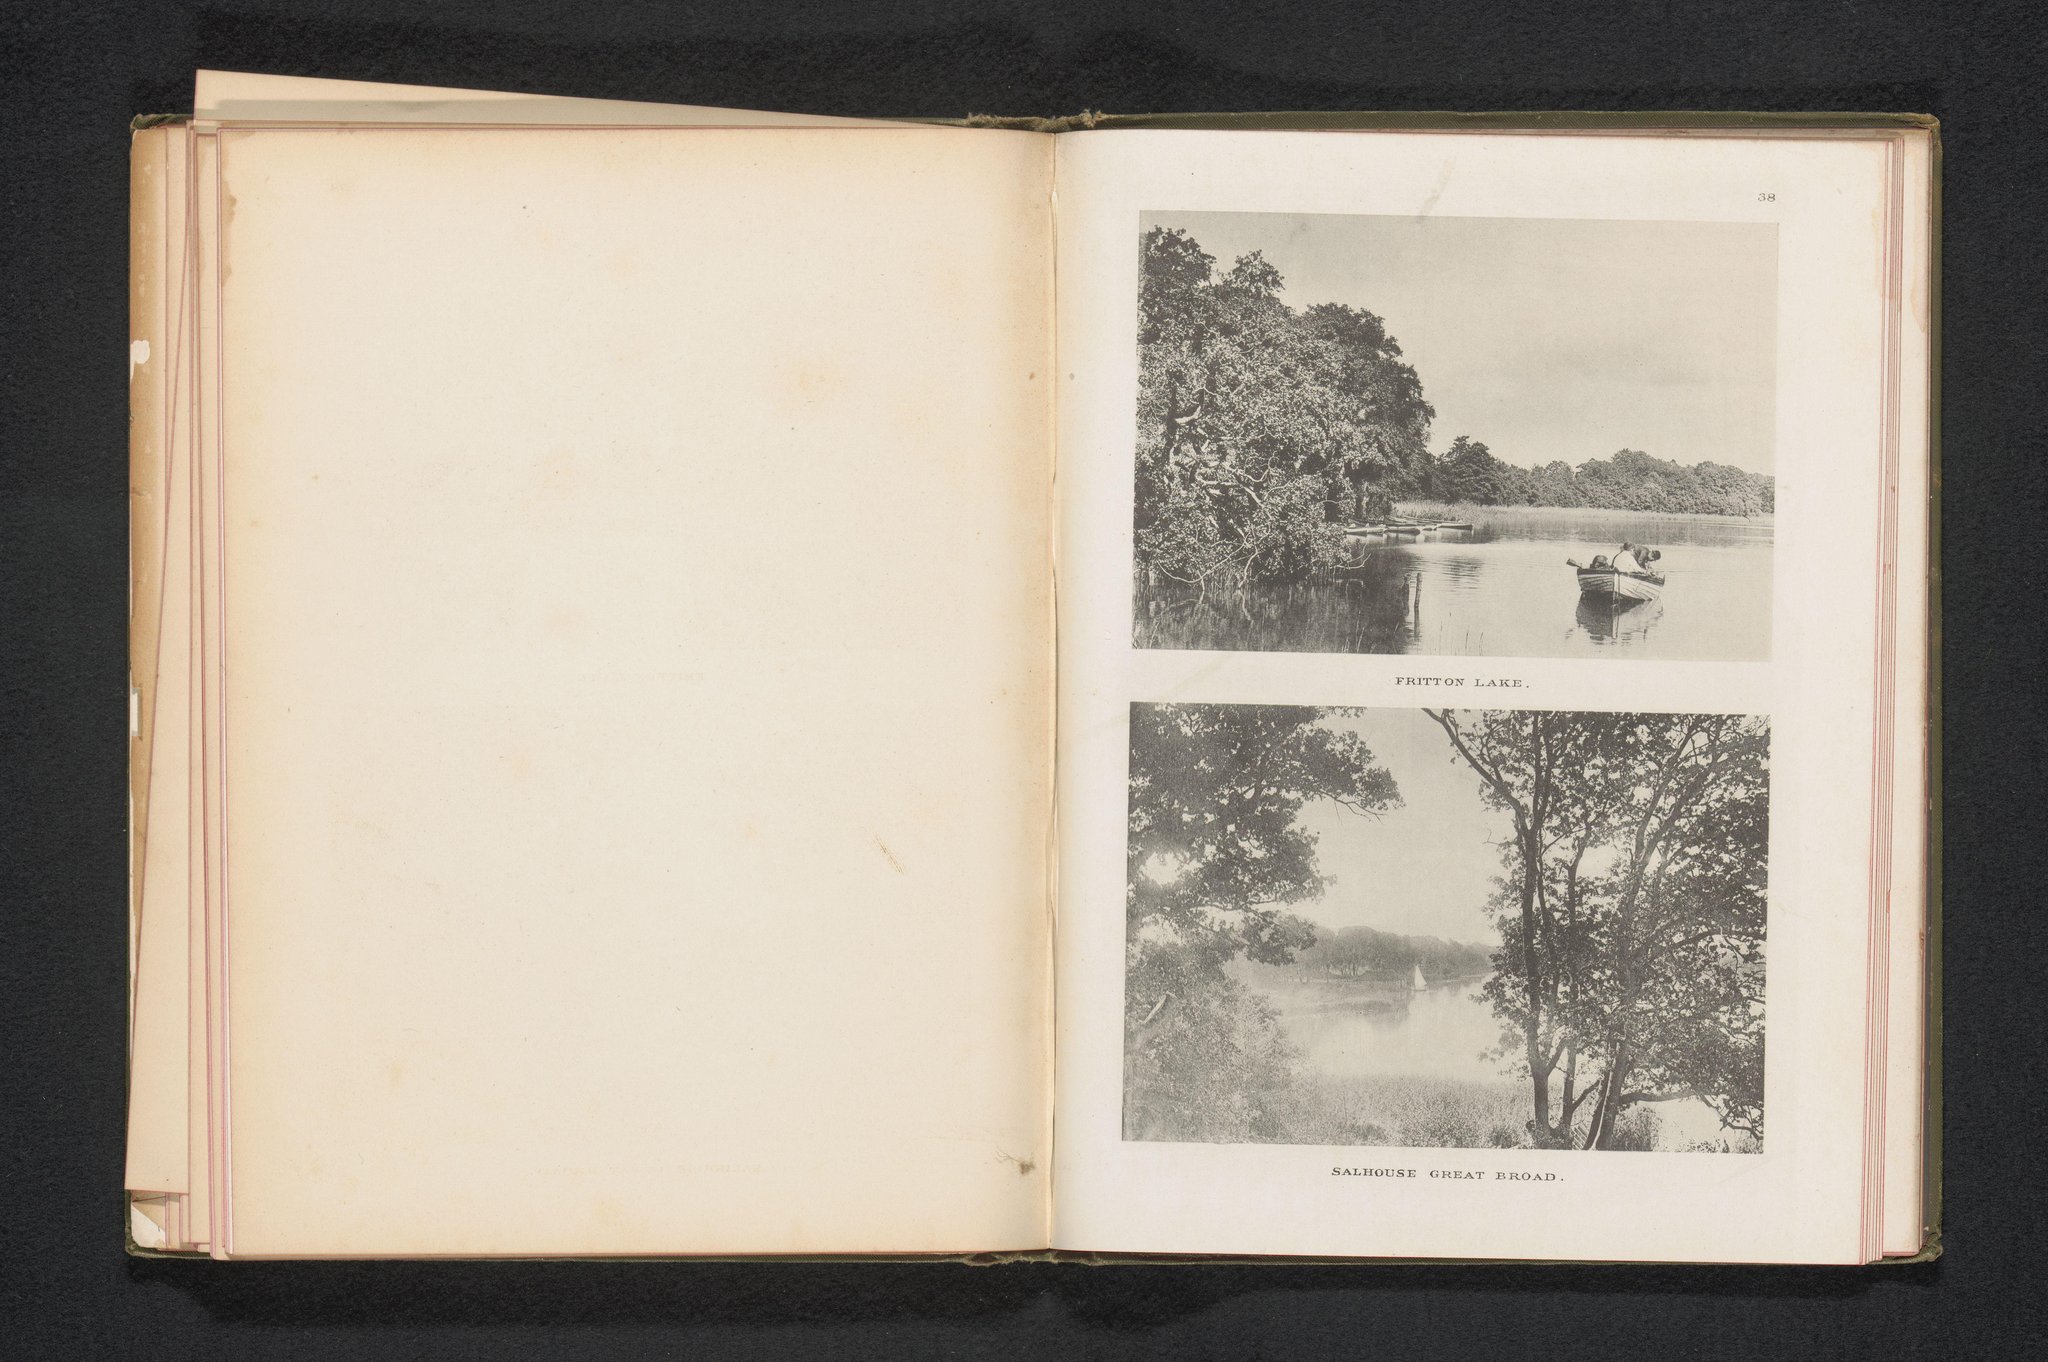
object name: page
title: Salhouse Great Broad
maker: john payne jennings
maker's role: fotograaf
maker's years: 1843-1926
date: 1886-1891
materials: paper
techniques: photograph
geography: salhouse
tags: landscapes with waters, waterscapes, seascapes (in the temperate zone), lake